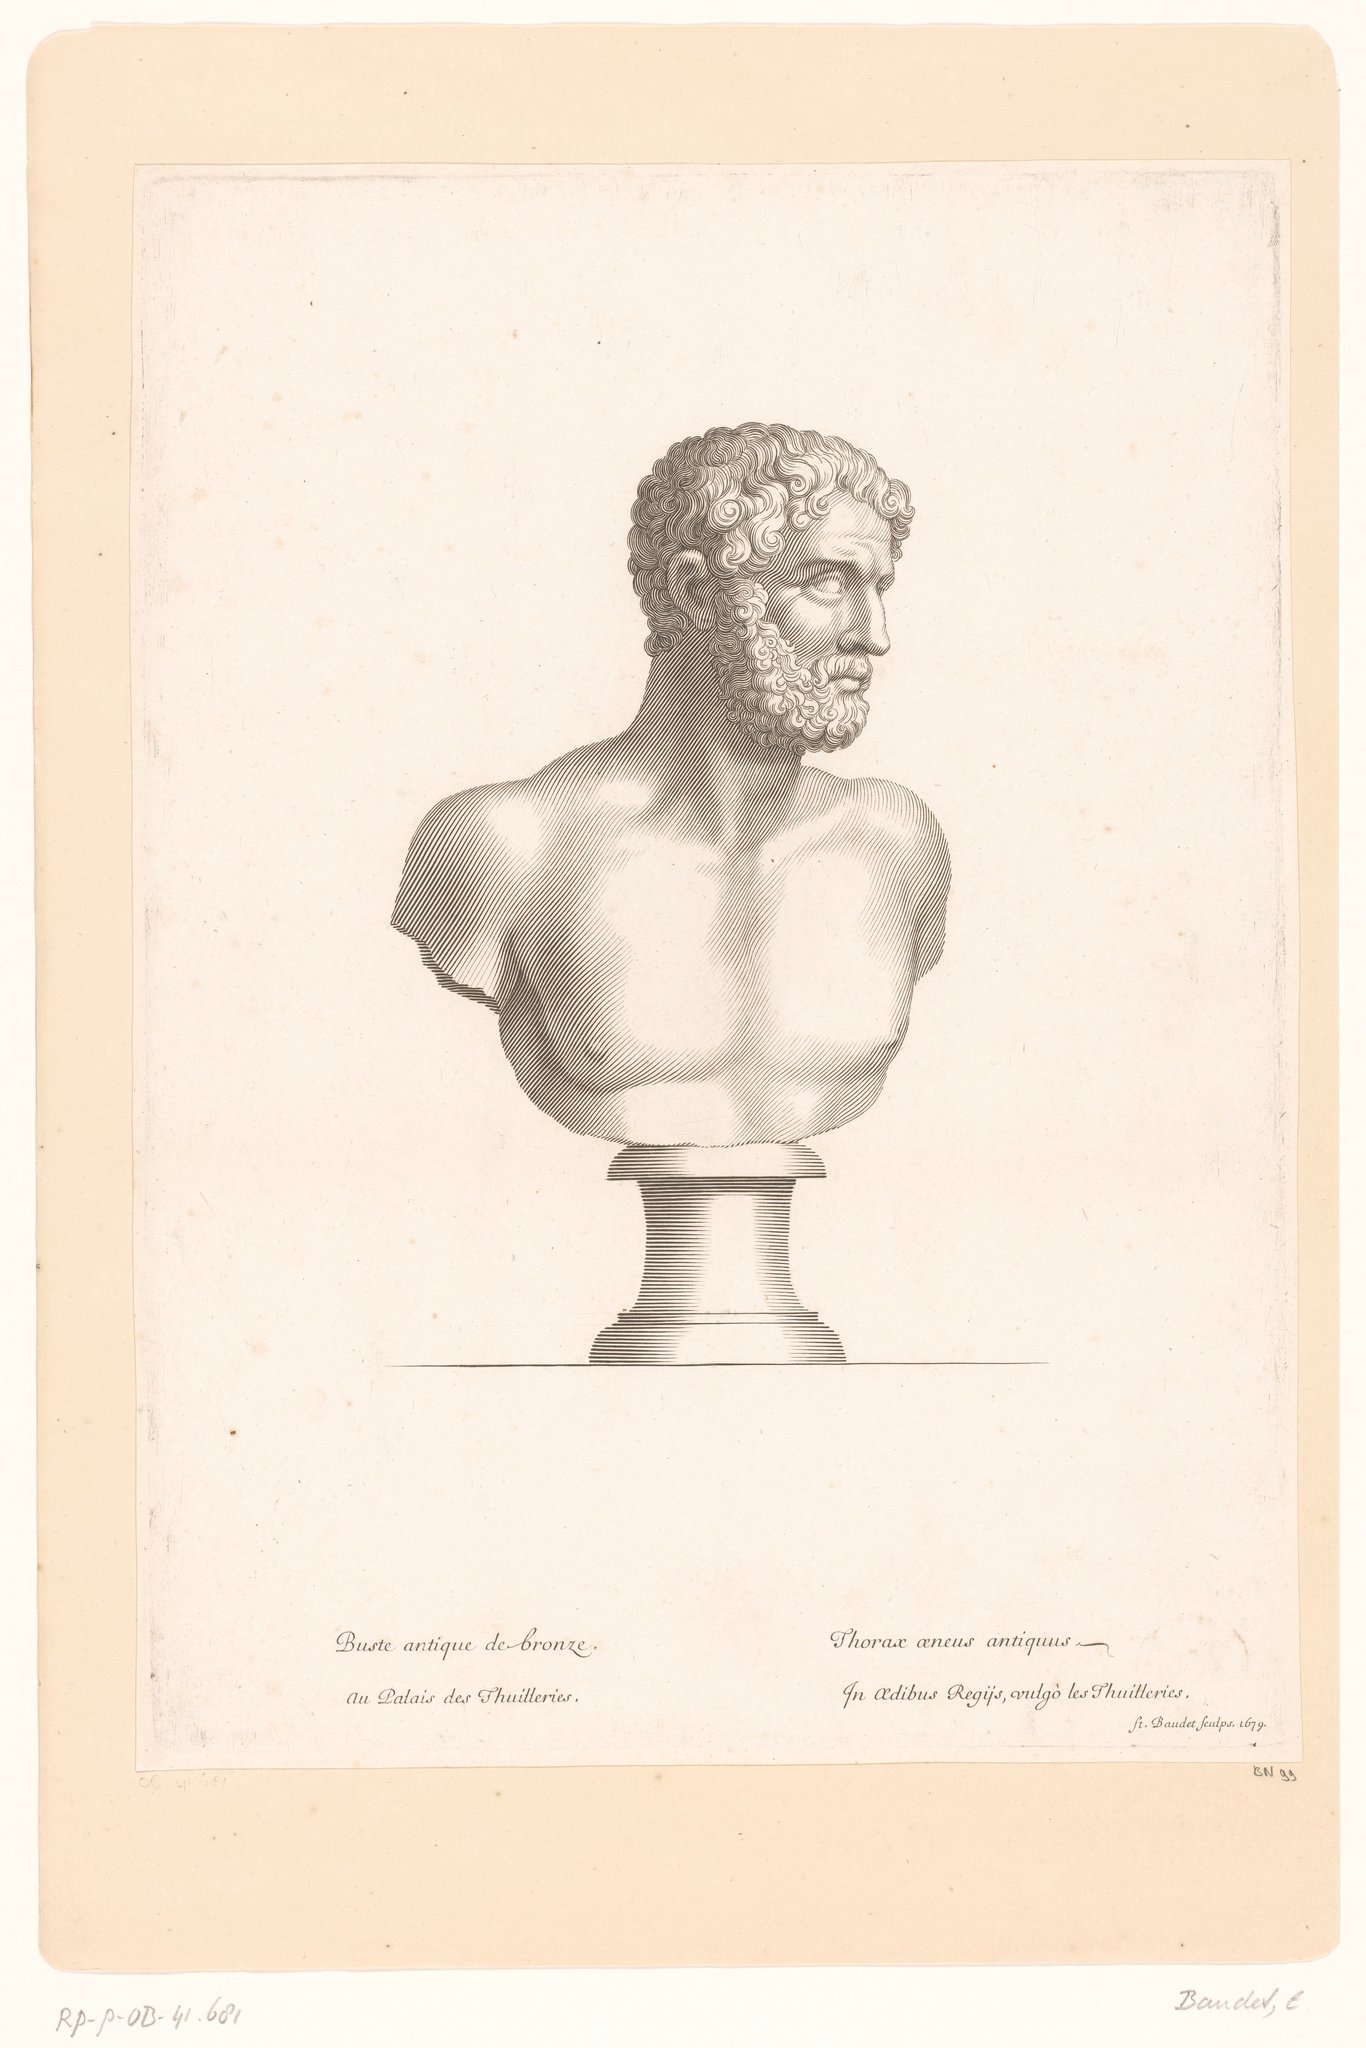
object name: print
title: Antieke buste van een bebaarde man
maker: etienne baudet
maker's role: print maker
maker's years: 1638-1711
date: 1679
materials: paper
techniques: engraving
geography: france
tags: chest, bust, piece of sculpture, reproduction of a piece of sculpture, tuileries palace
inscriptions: collector's mark: Lugt 240